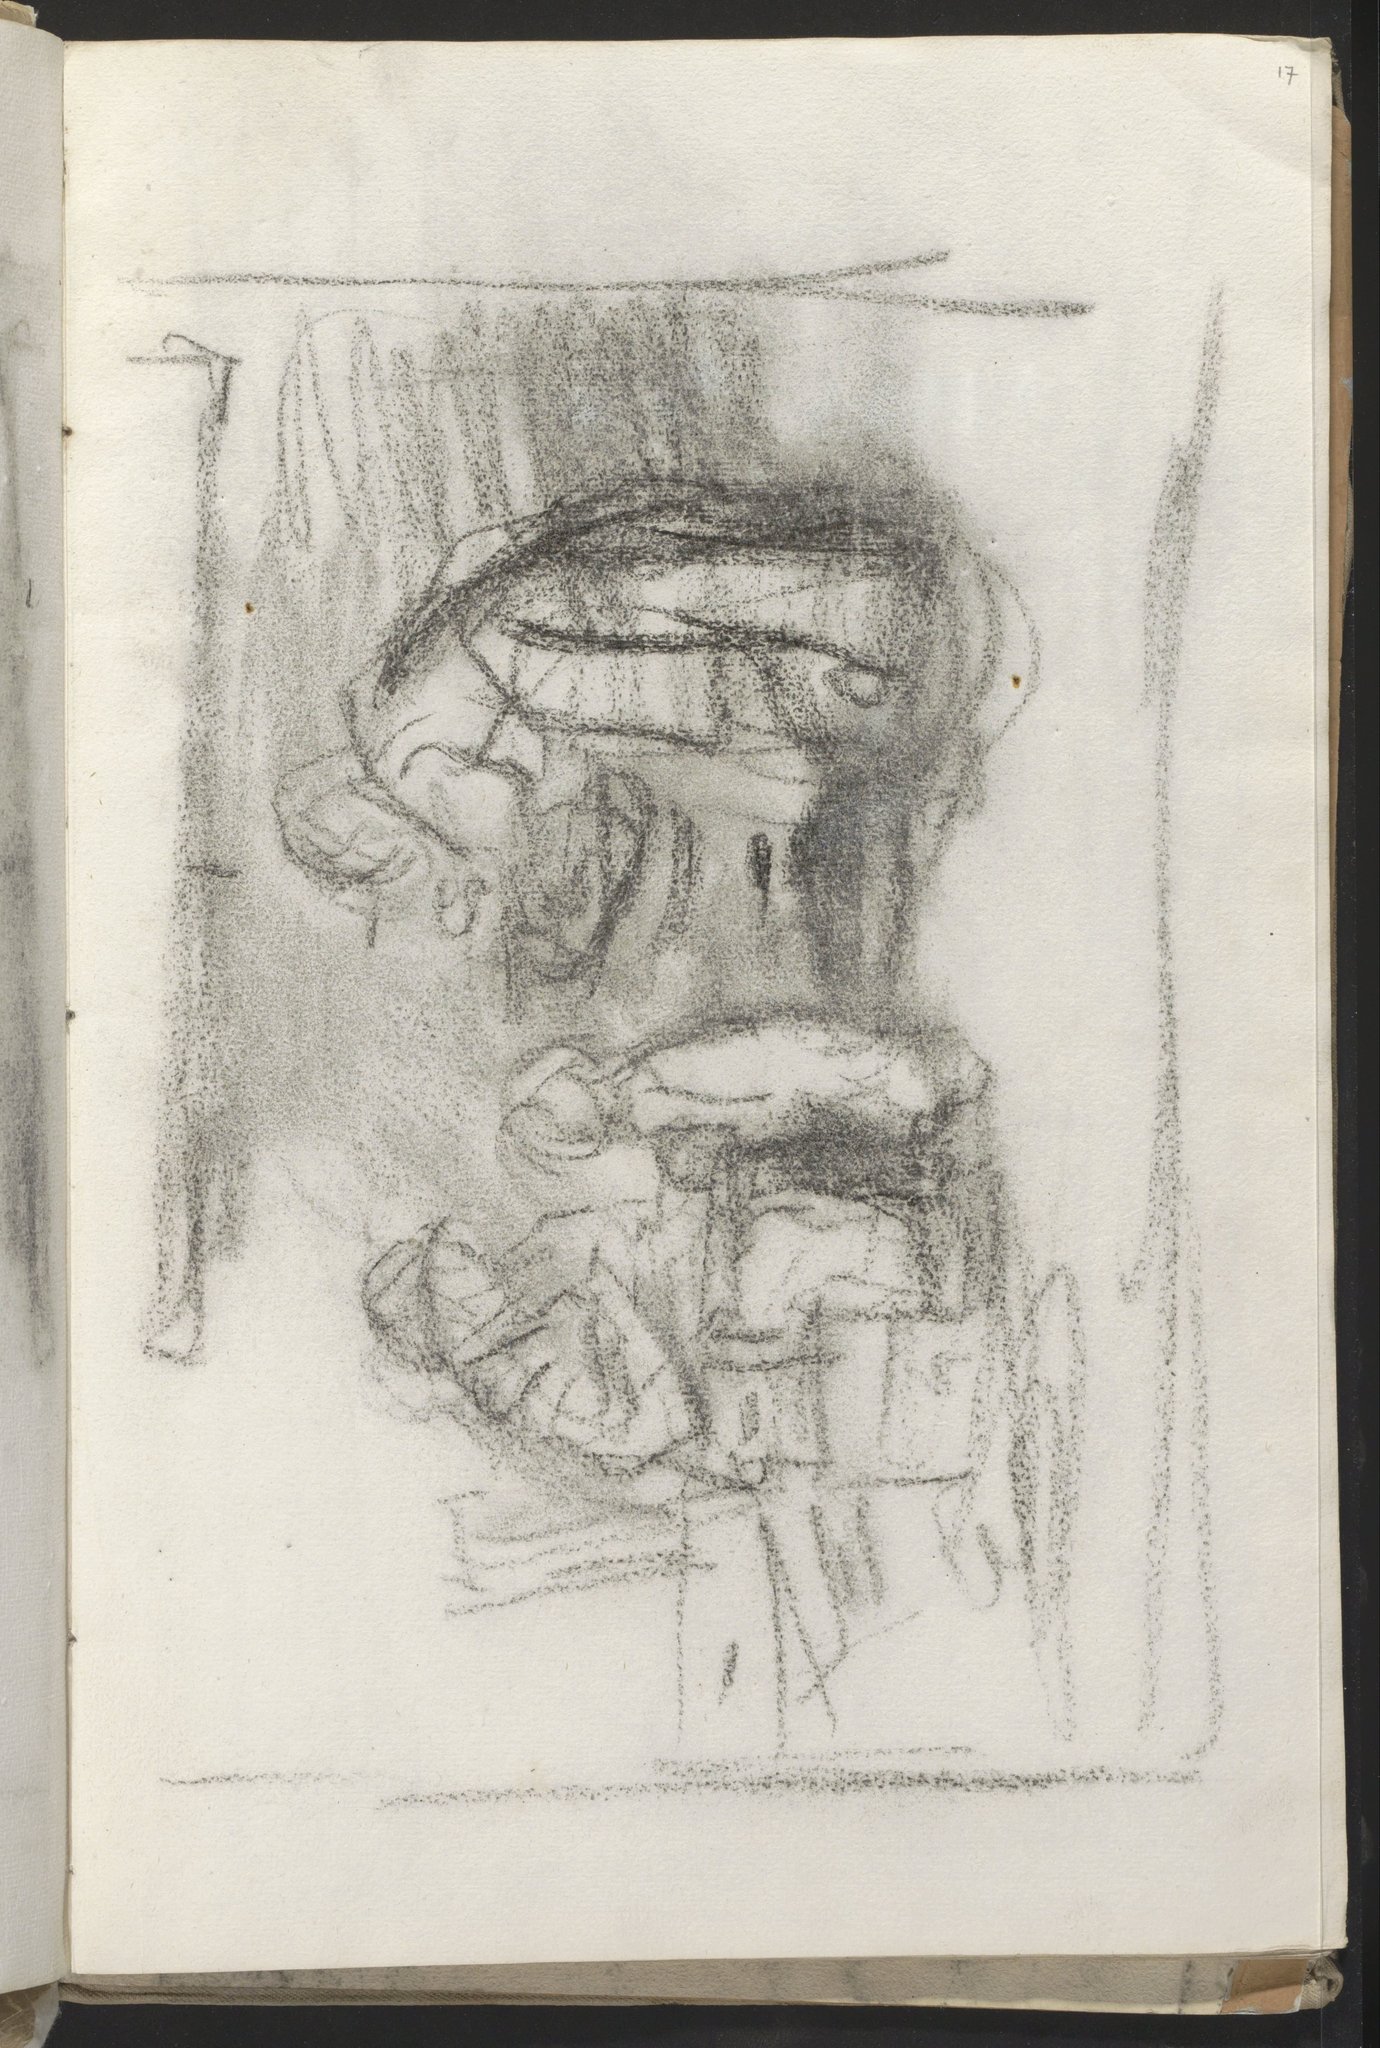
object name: sketchbook leaf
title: Interieur met twee vrouwen en een kind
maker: albert neuhuys (1844-1914)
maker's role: draughtsman, painter, print maker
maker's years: 1844-1914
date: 1854-1914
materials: charcoal, paper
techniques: stumping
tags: adult woman, child, interior of the house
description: Blad 17 recto uit een schetsboek met 53 bladen.